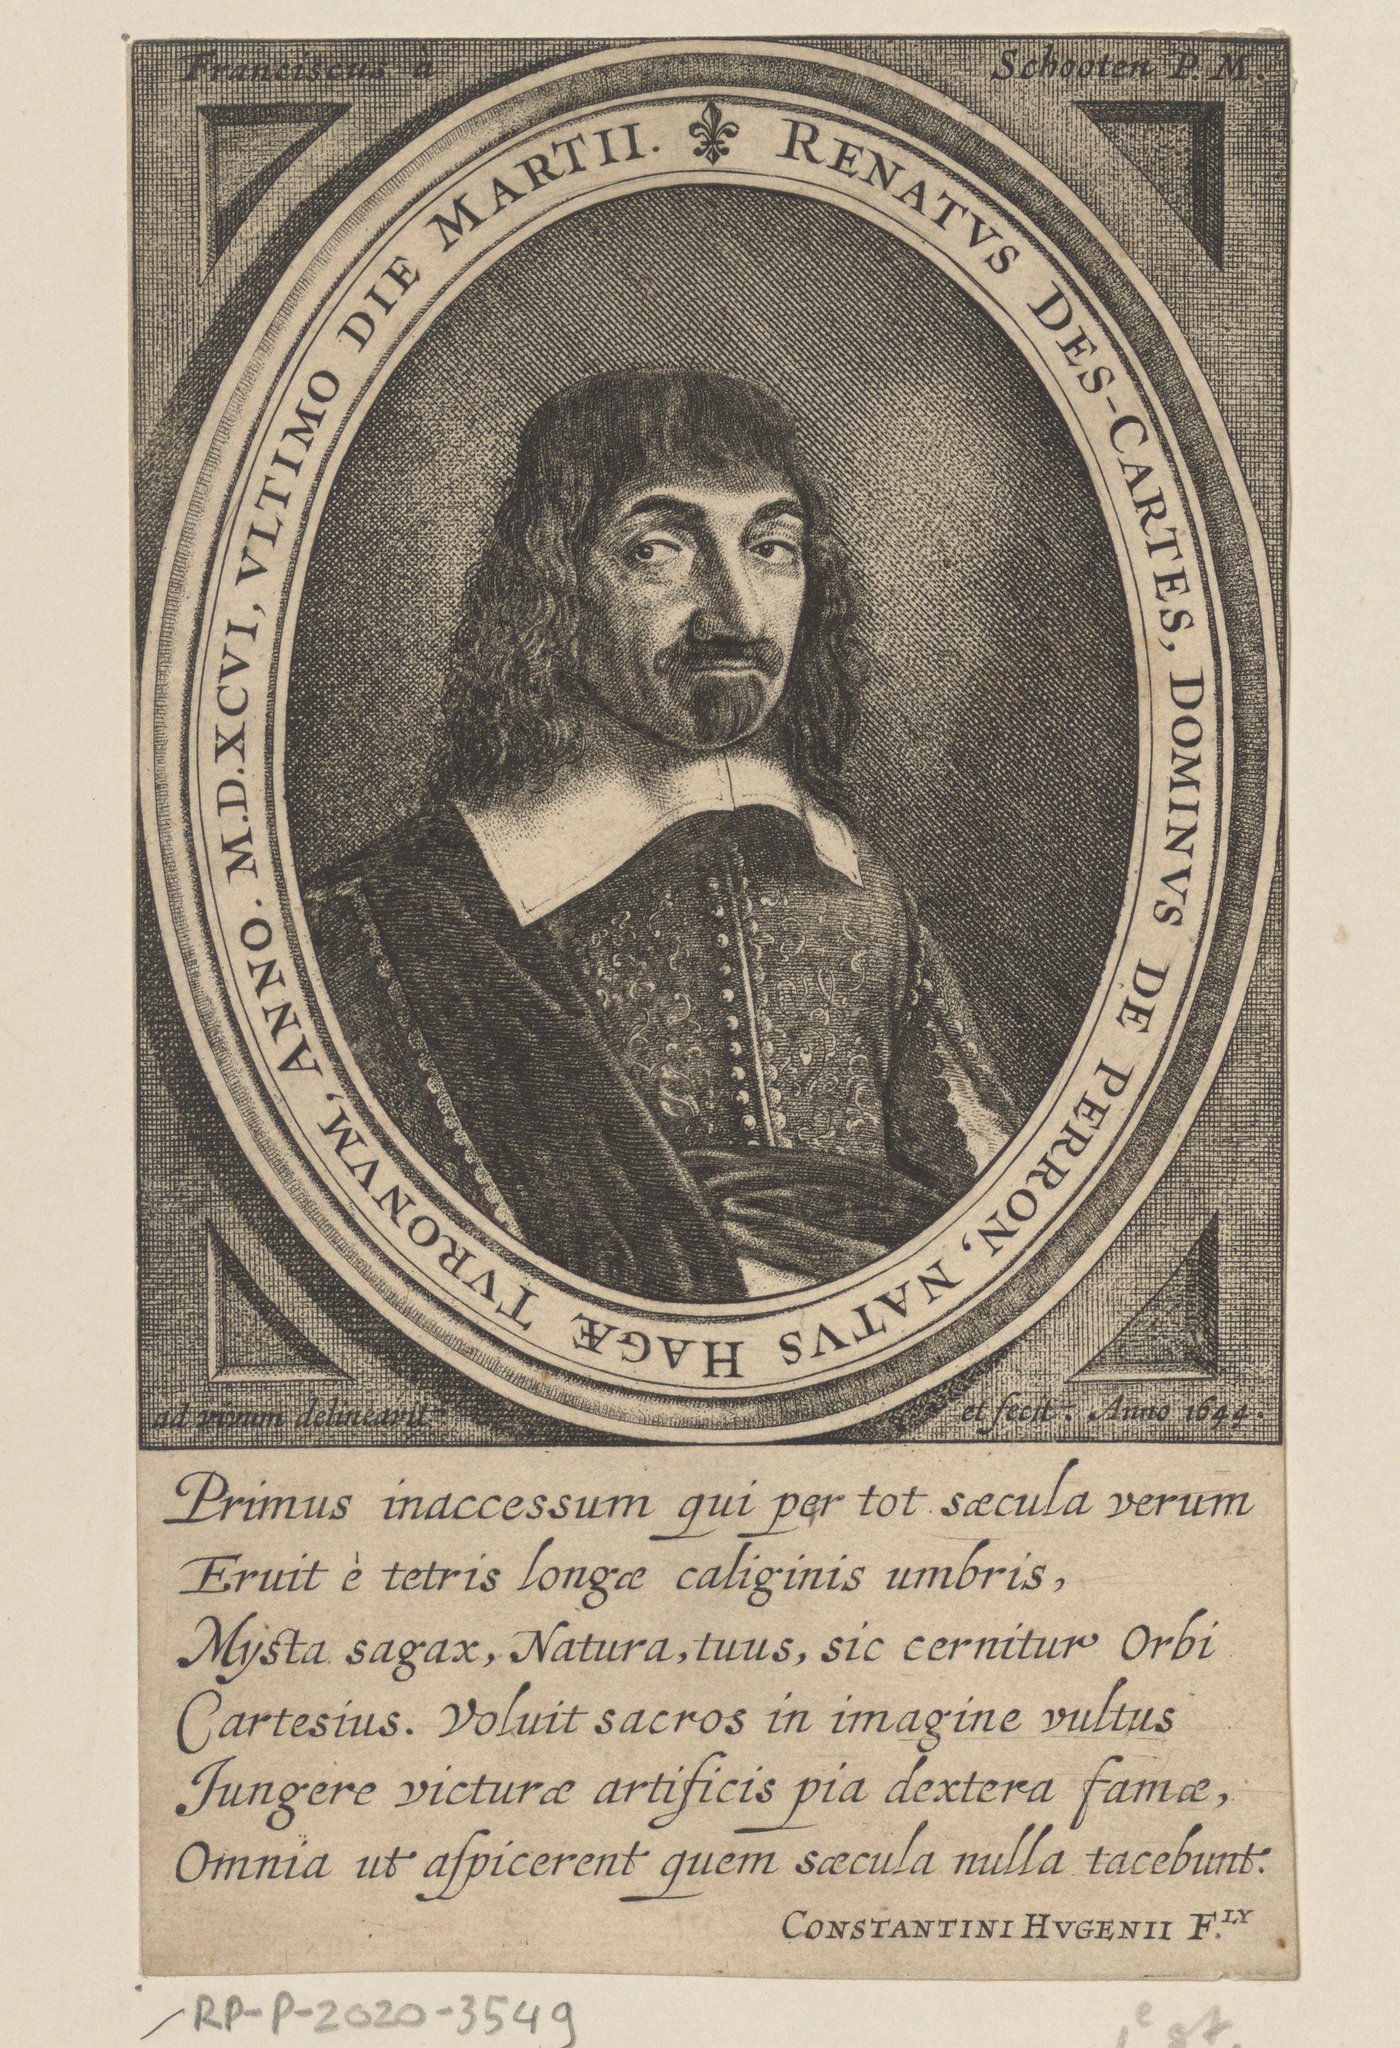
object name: print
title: Portret van René Descartes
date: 1644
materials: paper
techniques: engraving, etching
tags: rené descartes, scholar, philosopher, historical persons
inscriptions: collector's mark: Lugt 2228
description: Prent met tekst op verso gebruikt in: Descartes, René. Principia philosophiae. Amsterdam: Daniël Elsevier, 1664, dl. 2. Prent mogelijk voor het eerst gebruikt in: Descartes, René. Principia philosophiae. Amsterdam: Lodewijk en Daniël Elsevier, 1656.